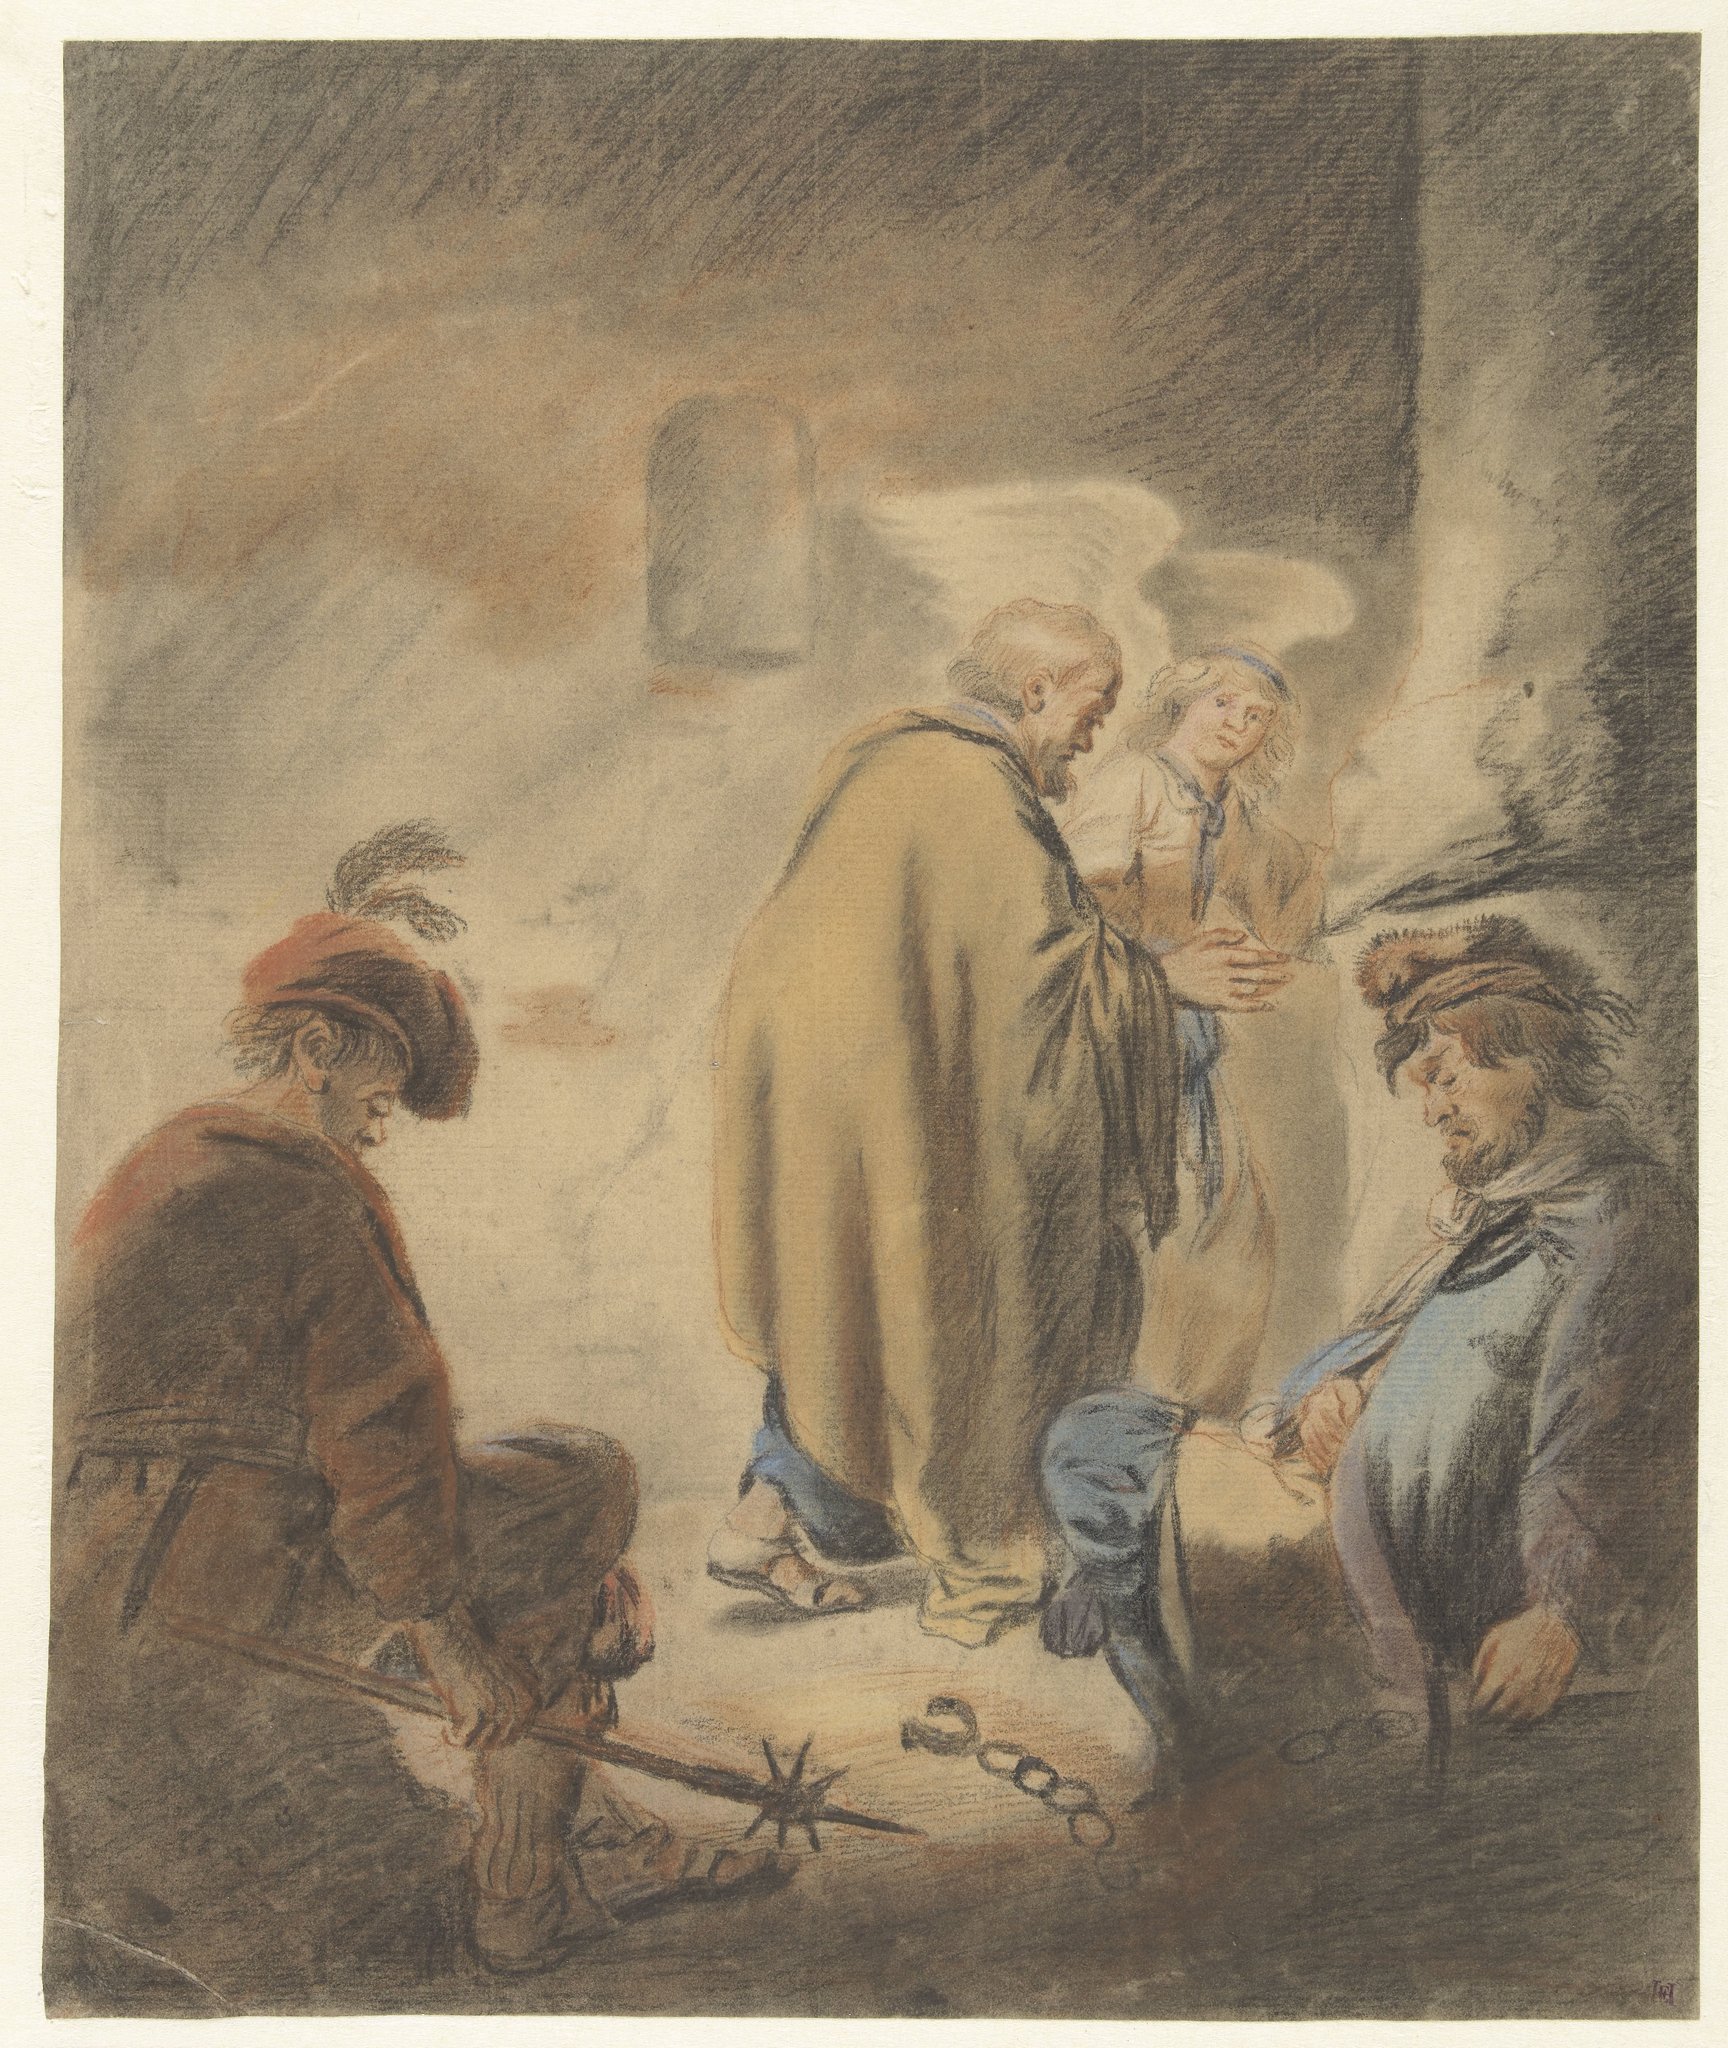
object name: drawing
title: Petrus uit de gevangenis bevrijd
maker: benjamin gerritsz cuyp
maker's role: draughtsman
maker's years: 1612-1652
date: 1632-1652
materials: chalk, paper, pastel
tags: prison, jail